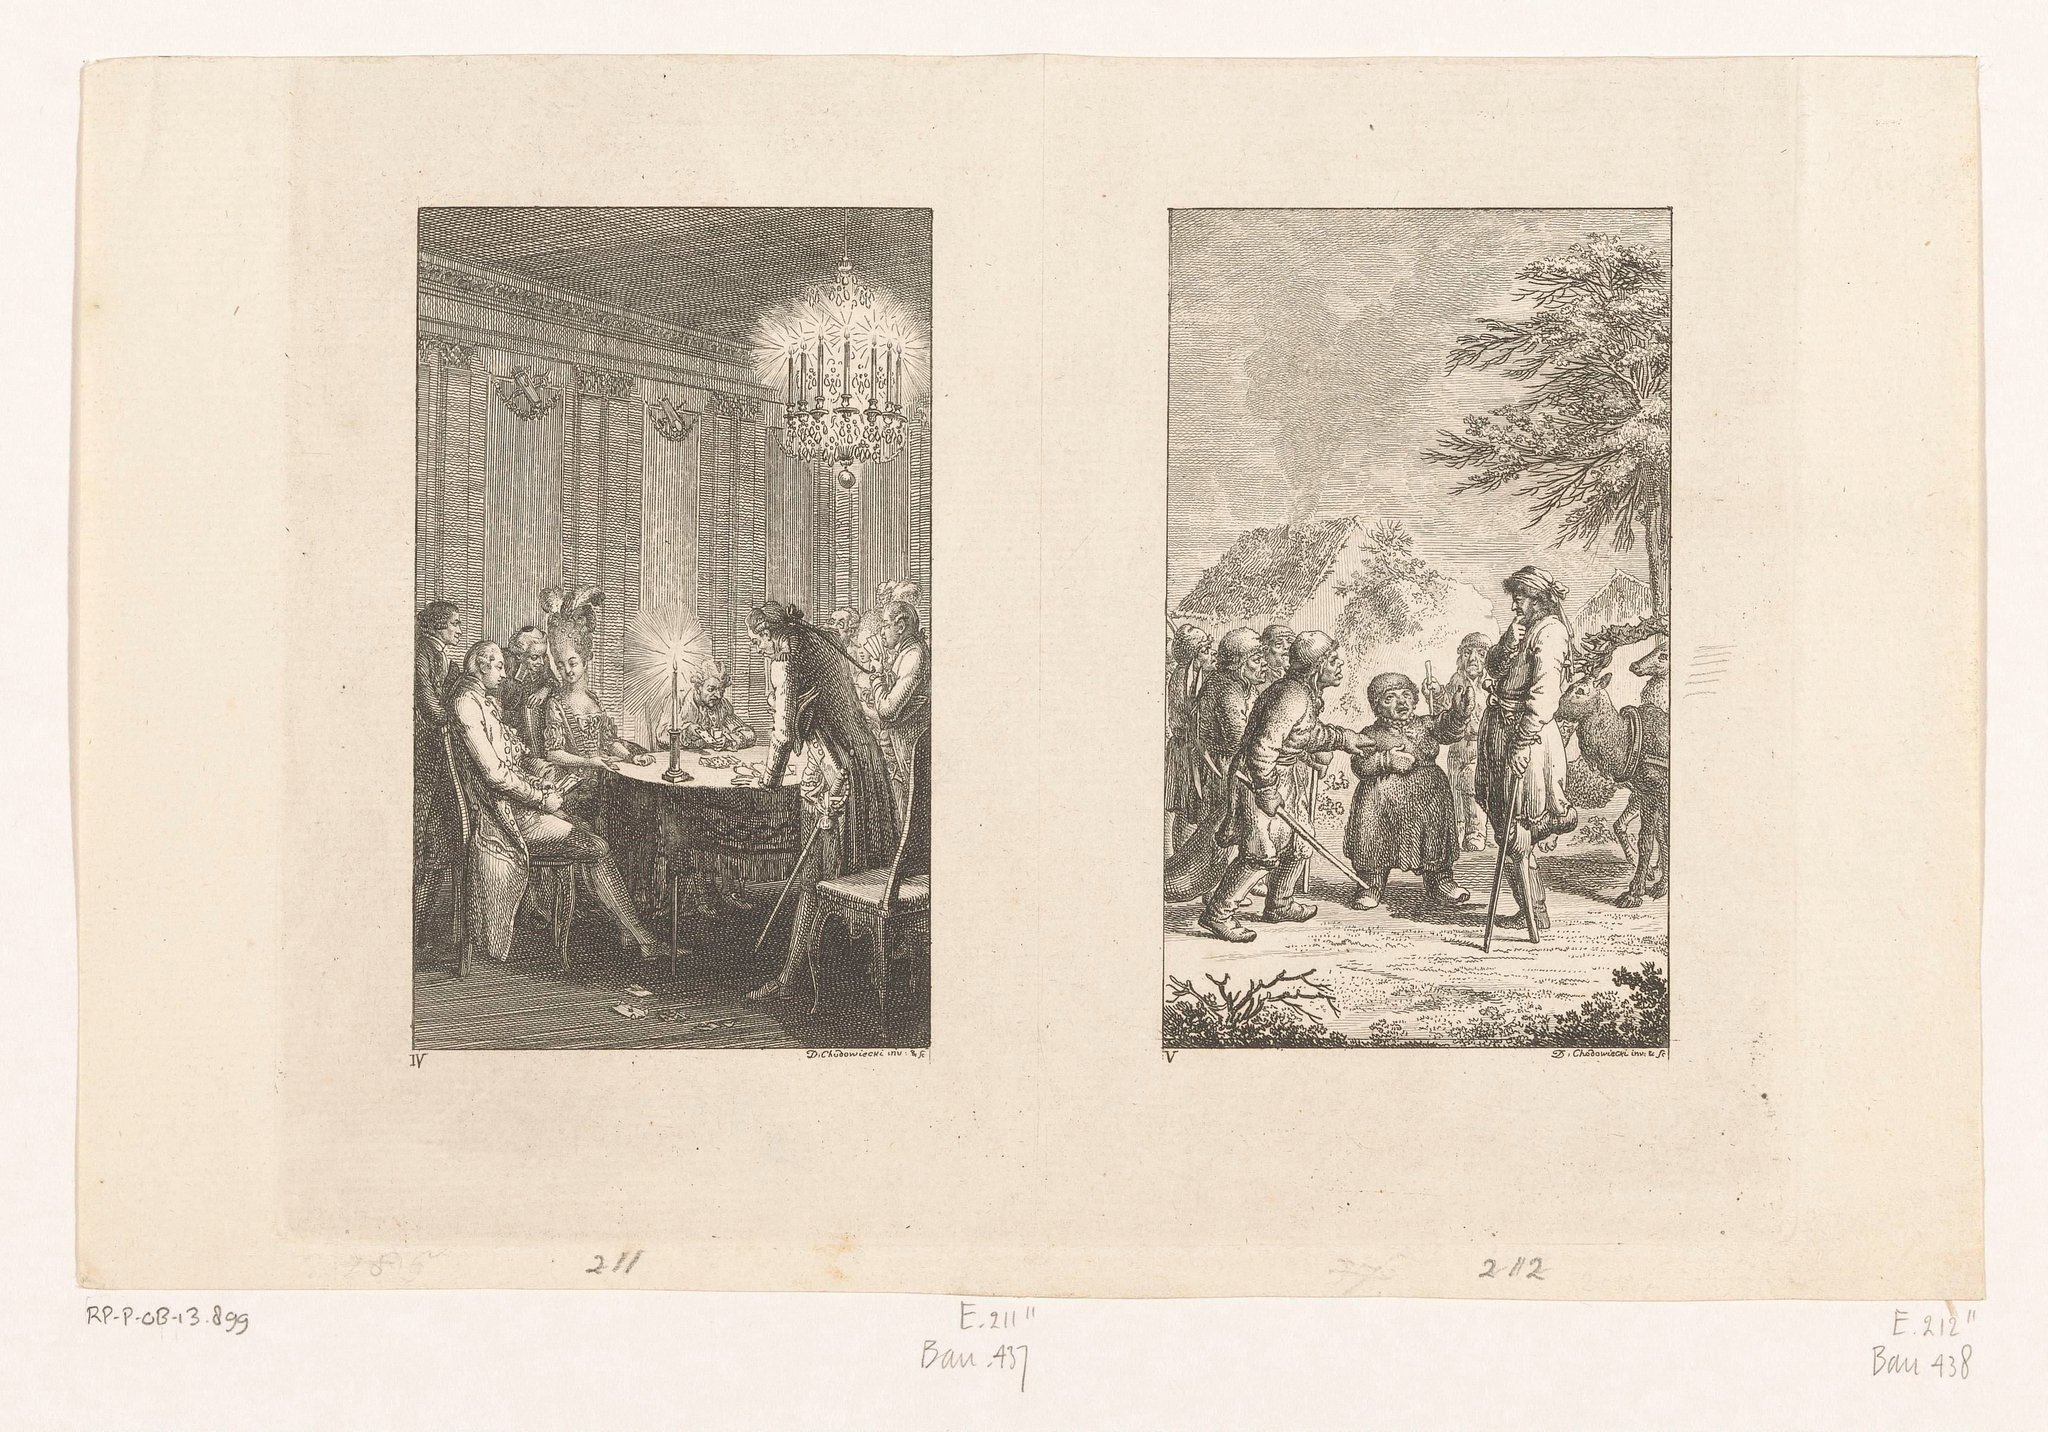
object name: print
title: Candide speelt kaart en Candide in Noorwegen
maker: daniel nikolaus chodowiecki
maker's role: draughtsman, print maker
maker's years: 1726-1801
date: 1778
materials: paper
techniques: etching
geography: berlin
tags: paris, voltaire, literature, wooden leg, card games, hoofed animals: reindeer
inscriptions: collector's mark: Lugt 2228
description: Links verliest Candide 50.000 francs met het kaartspel faro nadat hij als als vermogend man is teruggekeerd uit Eldorado. Rechts bevindt Candide zich tussen de inwoners van Noorwegen. Zijn linkerbeen is inmiddels afgezet. Genummerd: IV en V.